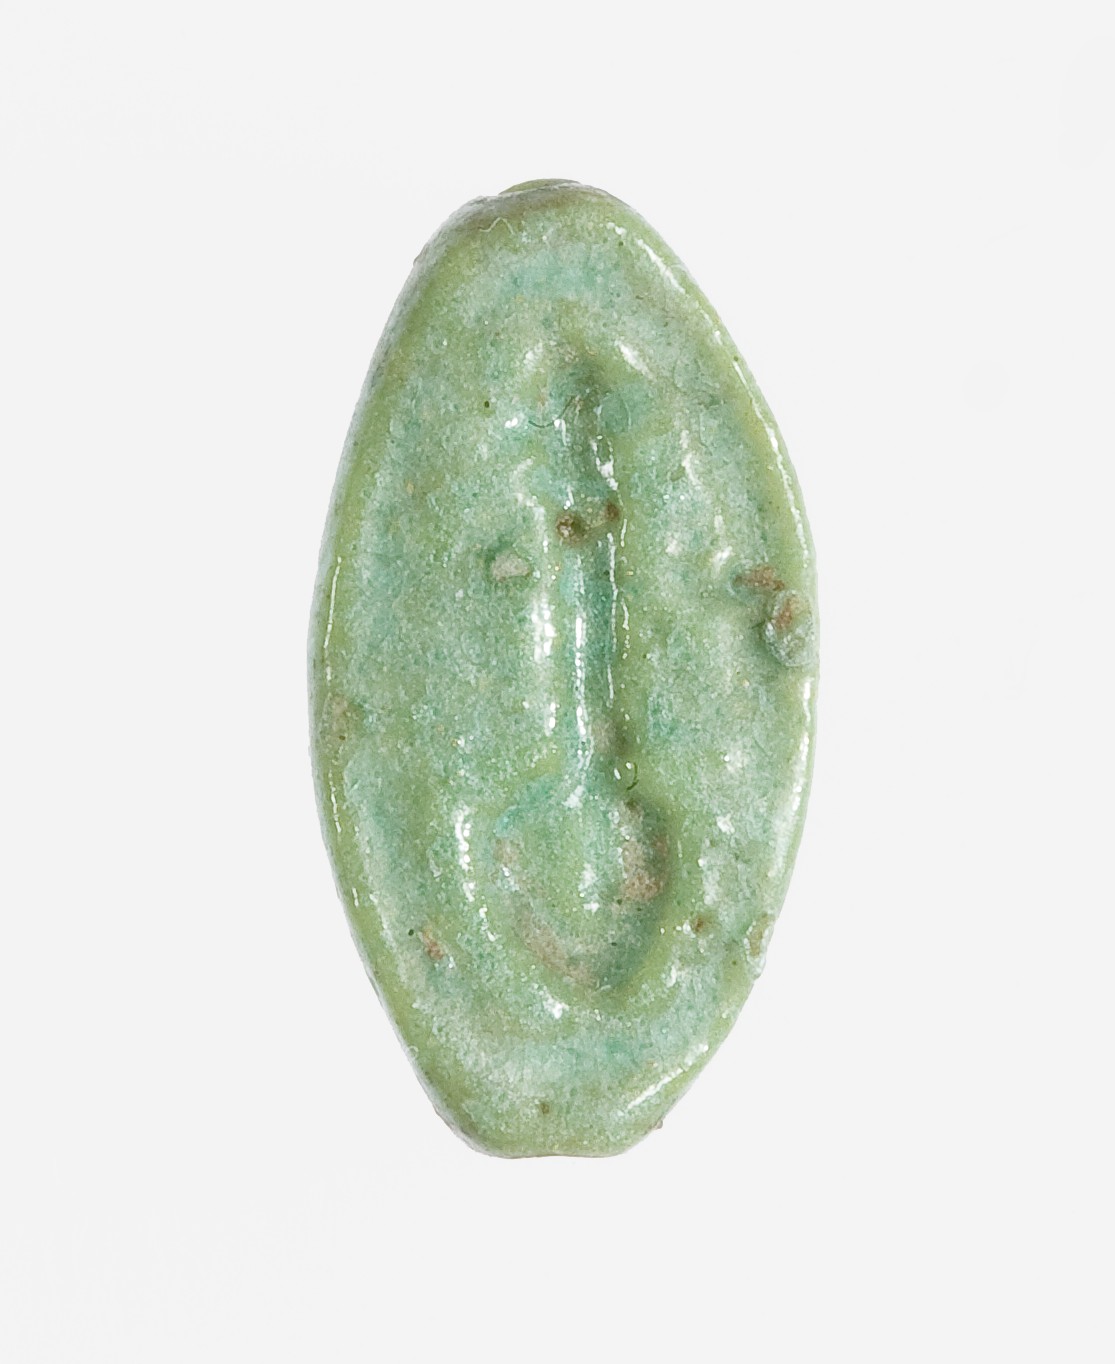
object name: cowroid, nefer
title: Cowroid Stamp Seal with a Nefer Hieroglyph Inscribed on the Base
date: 1390-1352 BCE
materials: faience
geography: egypt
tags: hieroglyphs